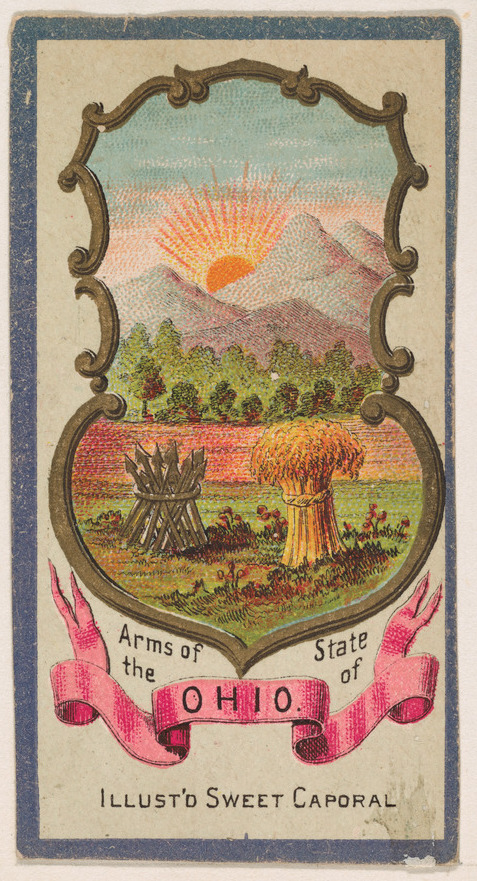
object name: print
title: Arms of the State of Ohio, from the Military Series (N224) issued by Kinney Tobacco Company to promote Sweet Caporal Cigarettes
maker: kinney brothers tobacco company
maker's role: publisher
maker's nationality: american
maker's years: 1869-2011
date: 1888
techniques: color lithograph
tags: sun,mountains,landscapes,coat of arms